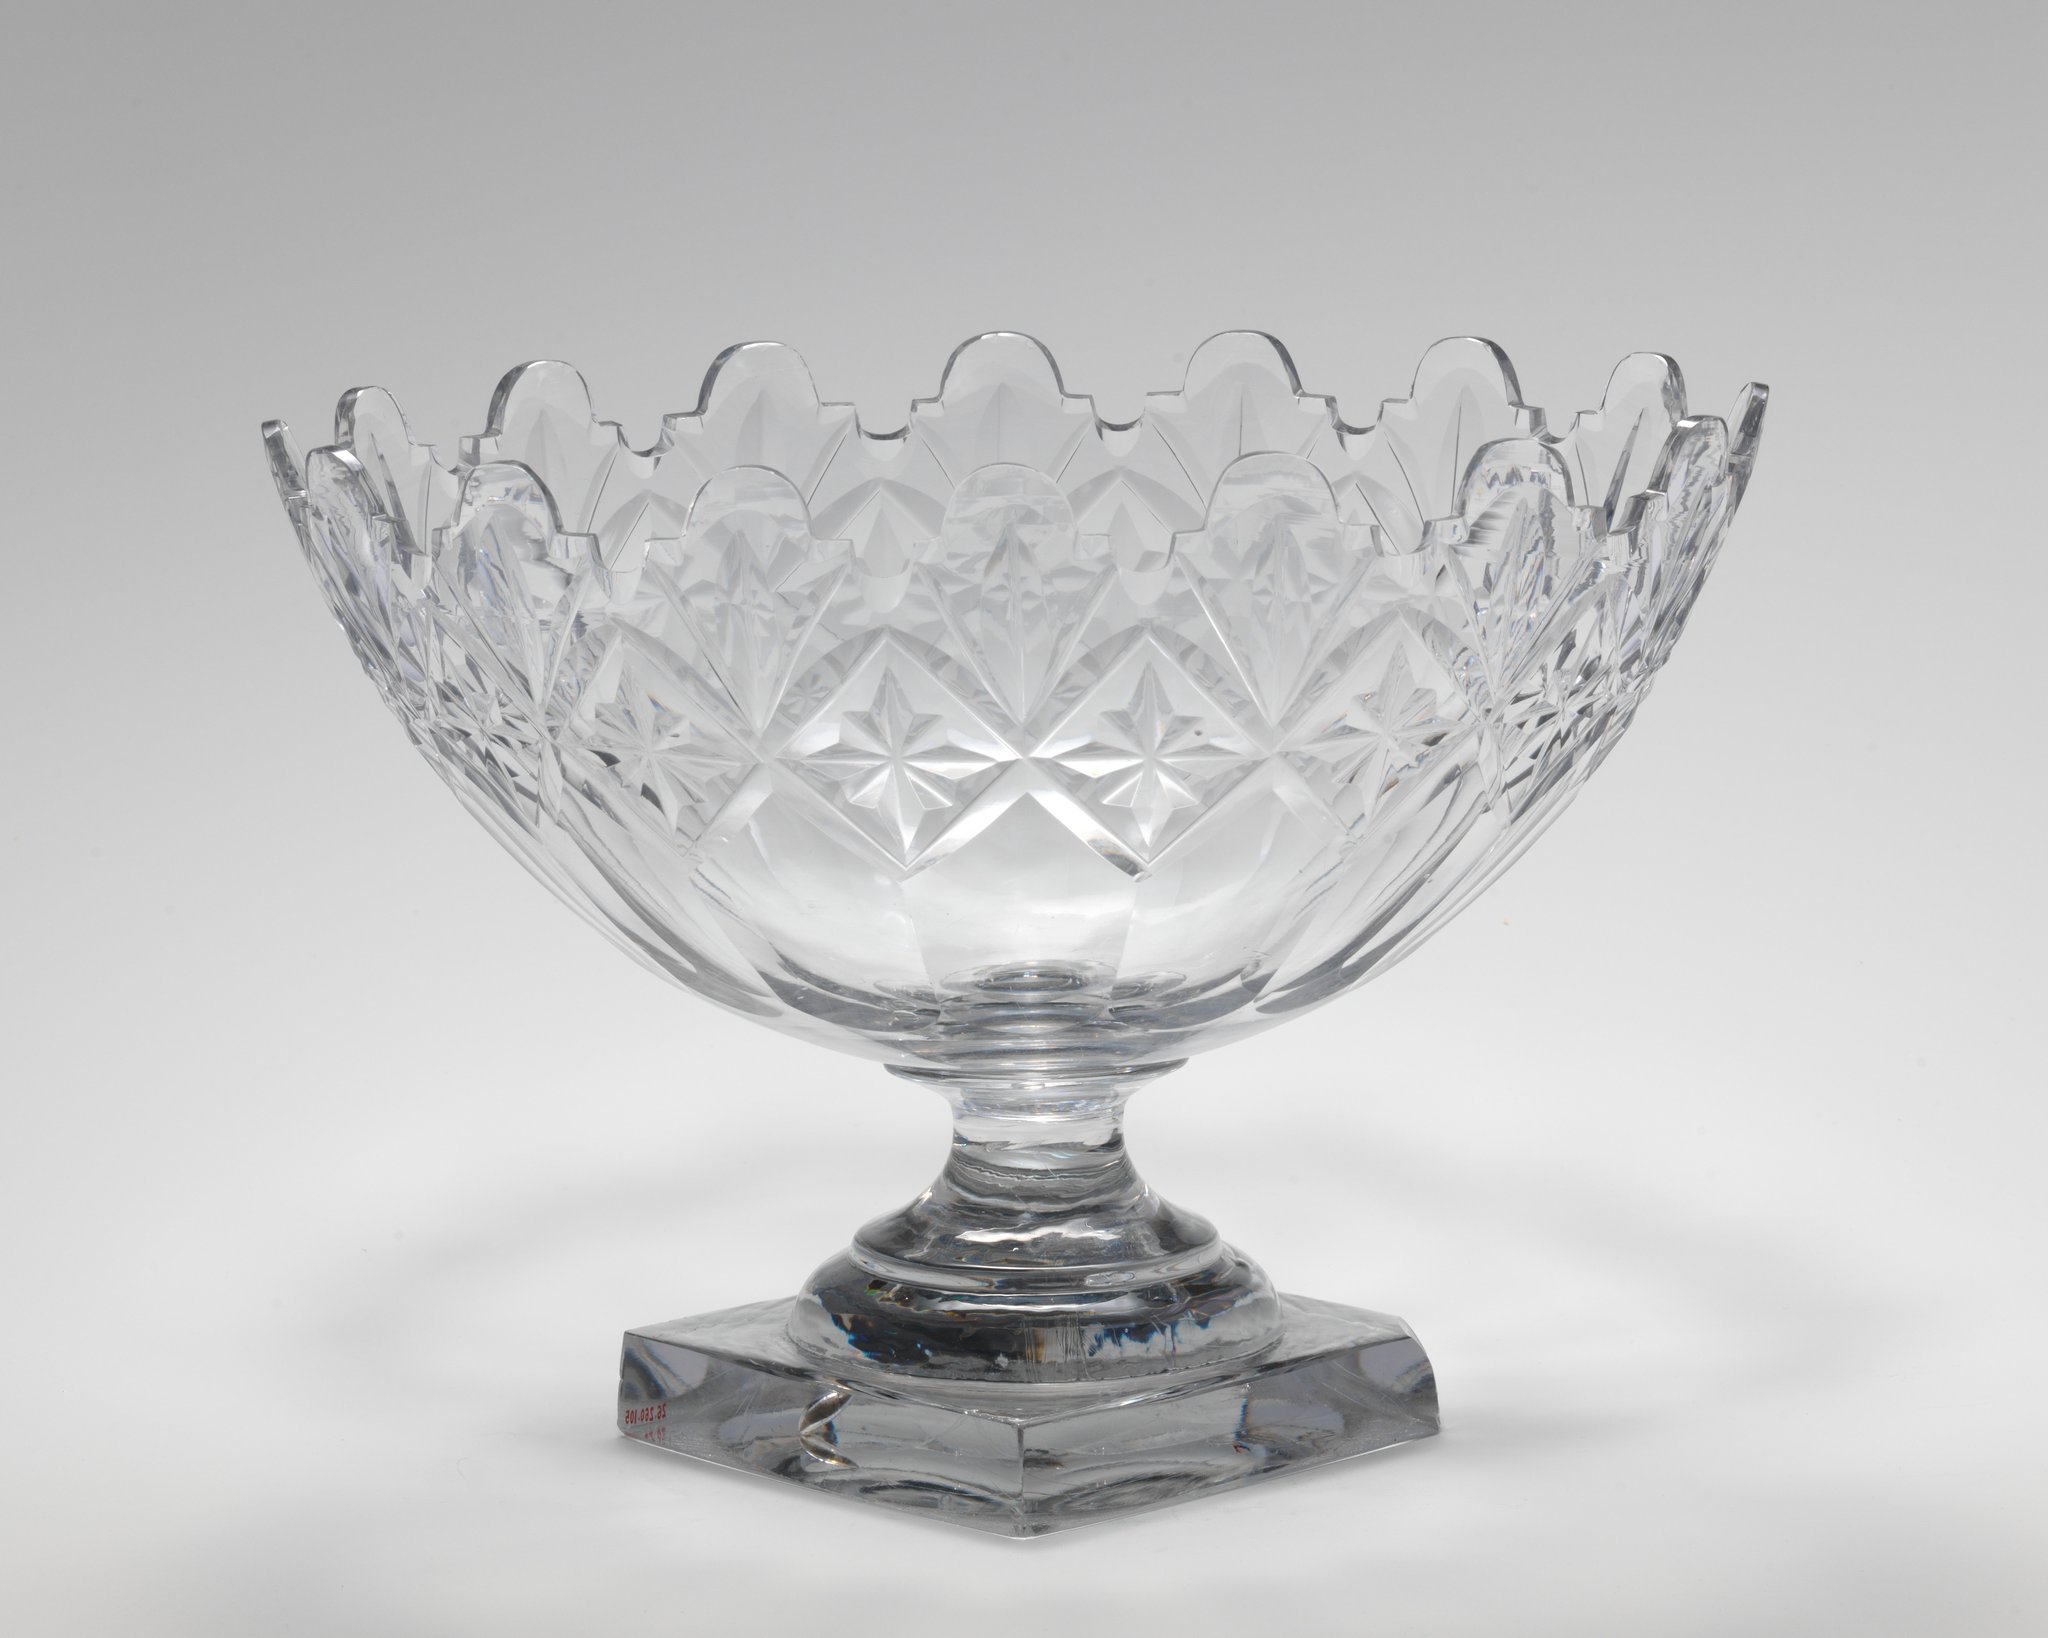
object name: bowl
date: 1801-1833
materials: glass